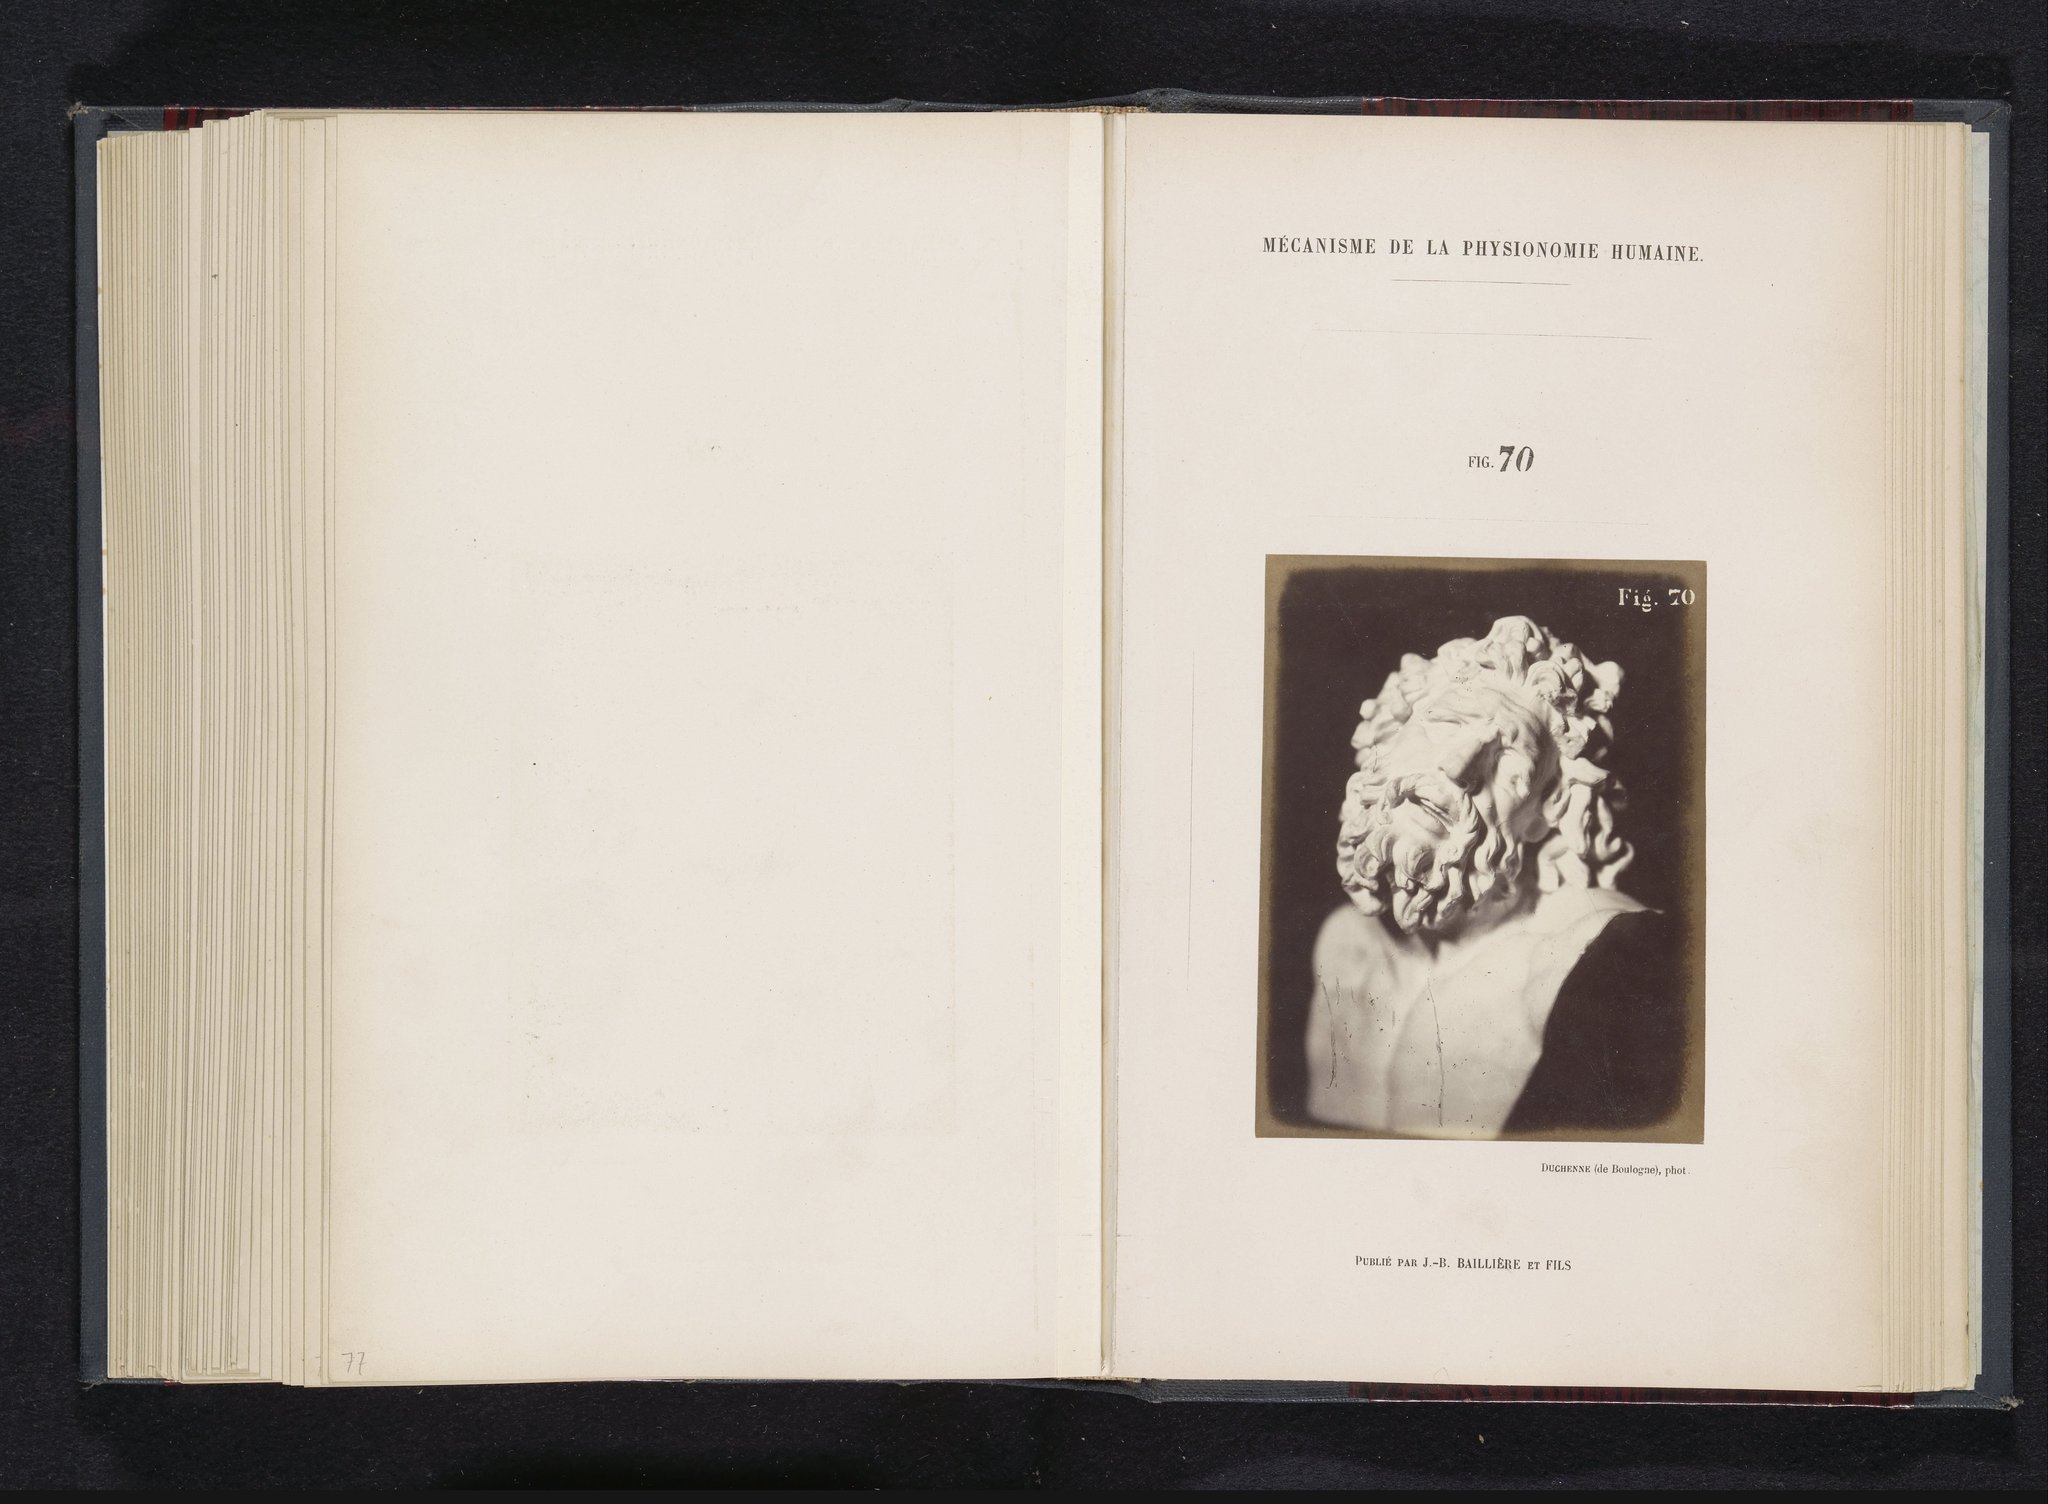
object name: photograph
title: Beeld van 'Laocoon de Rome'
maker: guillaume benjamin amand duchenne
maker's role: fotograaf, medicus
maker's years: 1806-1875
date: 1860-1862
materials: paper, photographic support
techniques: albumen print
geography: france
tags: face, physiology and anatomy ~ nervous system, neurology, physiology and anatomy, morphology of facial expression, piece of sculpture, reproduction of a piece of sculpture, physiognomy, experiment, test ~ science and technology, france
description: Ongenummerde pagina met foto 70 uit Mécanisme de la physionomie humaine ou analyse électro-physiologique de l'expression des passions (Atlas).